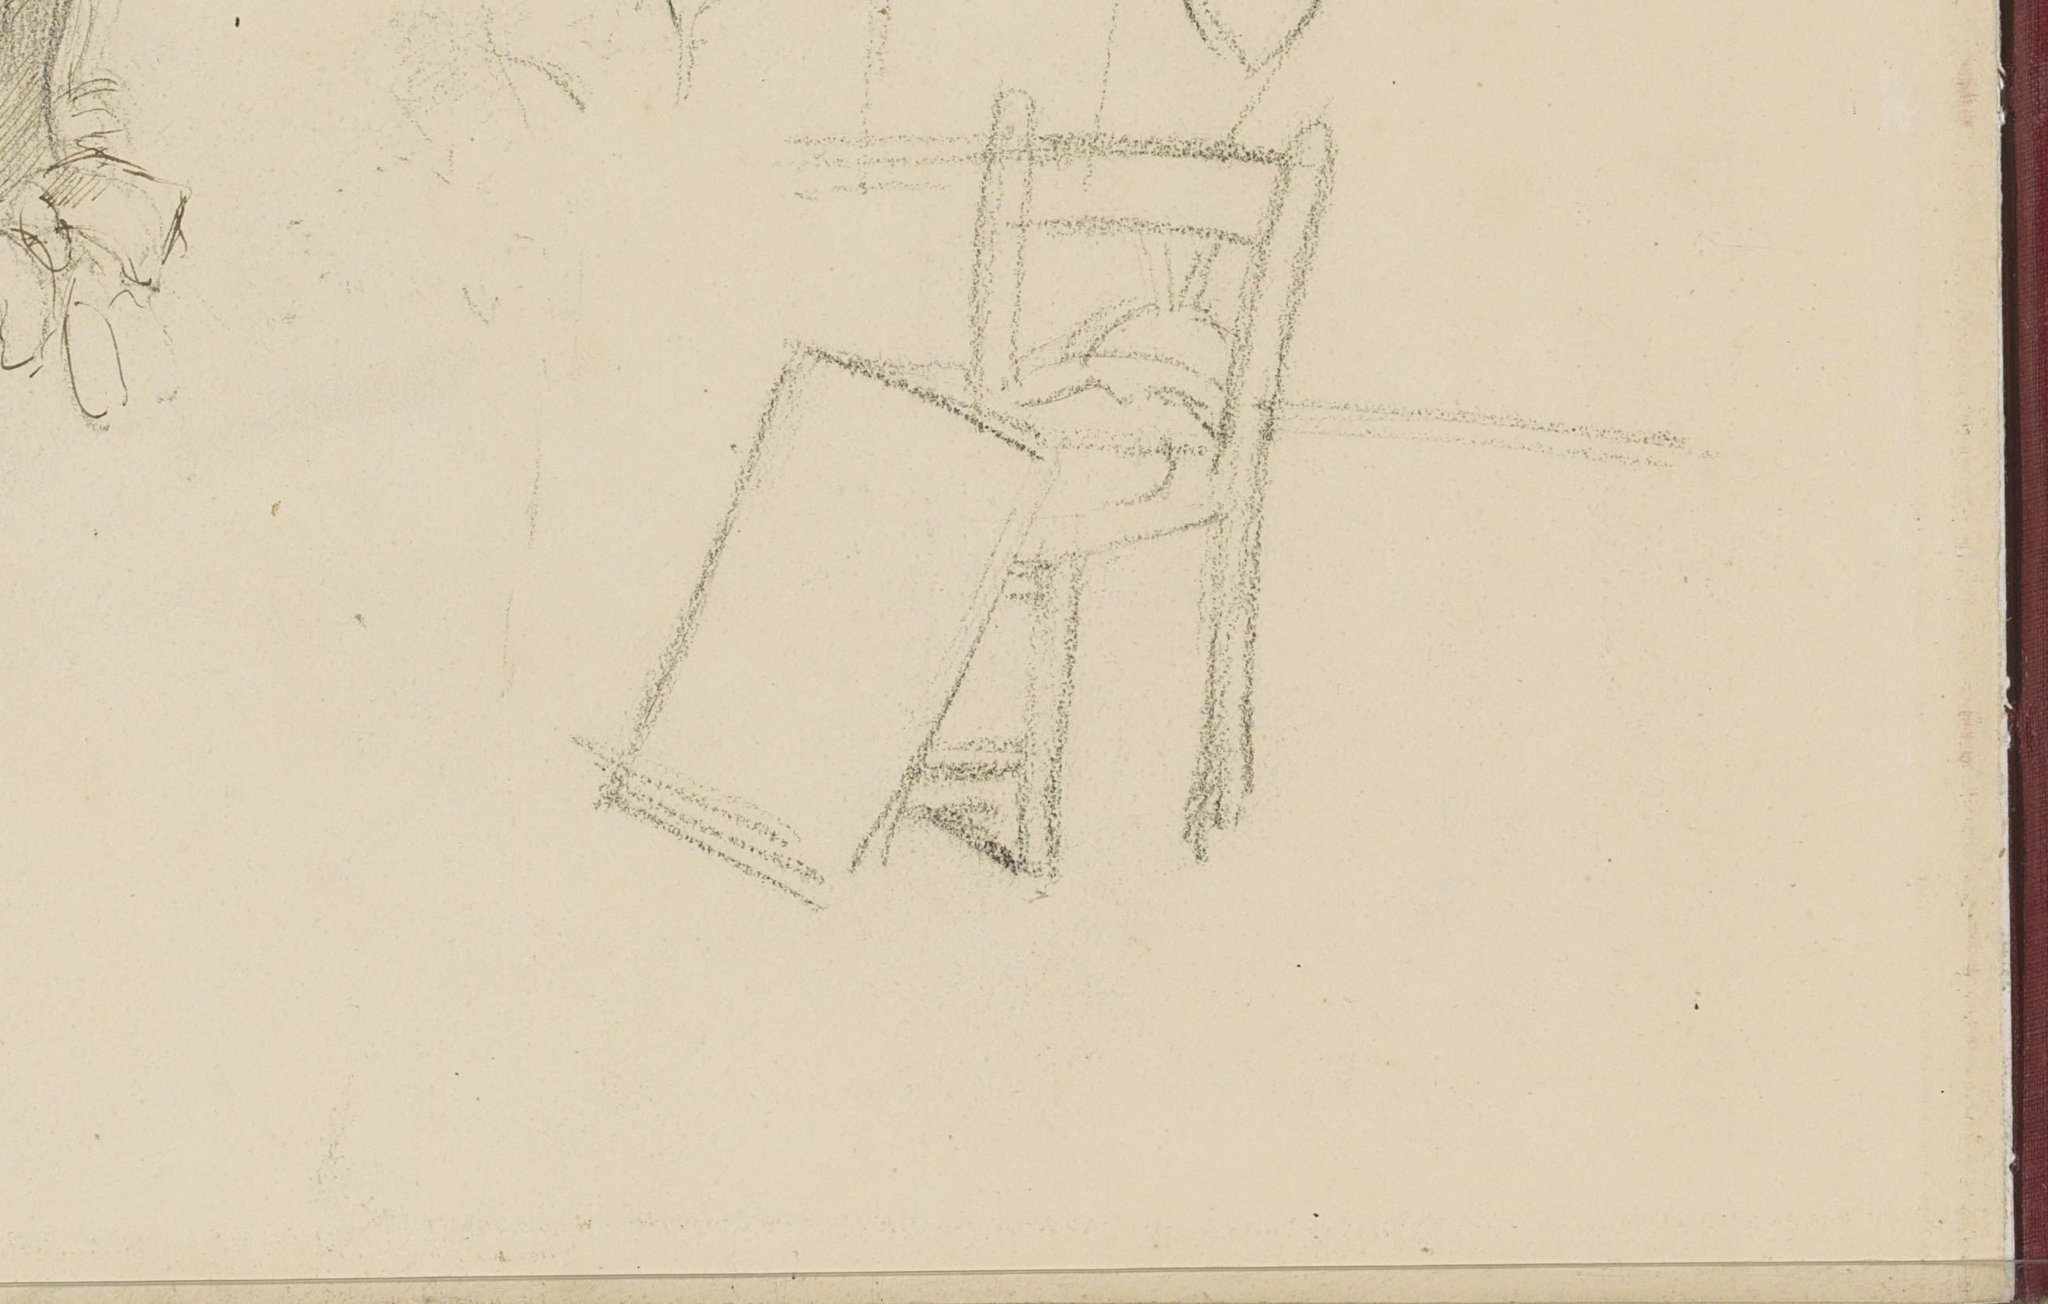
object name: sketchbook leaf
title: Vrouwenkop en een schildersdoek leunend tegen een stoel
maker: jozef israëls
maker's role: draughtsman, painter, print maker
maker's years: 1824-1911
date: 1834-1911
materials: chalk, ink, paper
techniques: pen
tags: head (human) (+ adult female (human being)), frame of painting, etc. (+ linen, cloth ~ arts), chair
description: Blad 25 verso uit een schetsboek met 25 bladen.